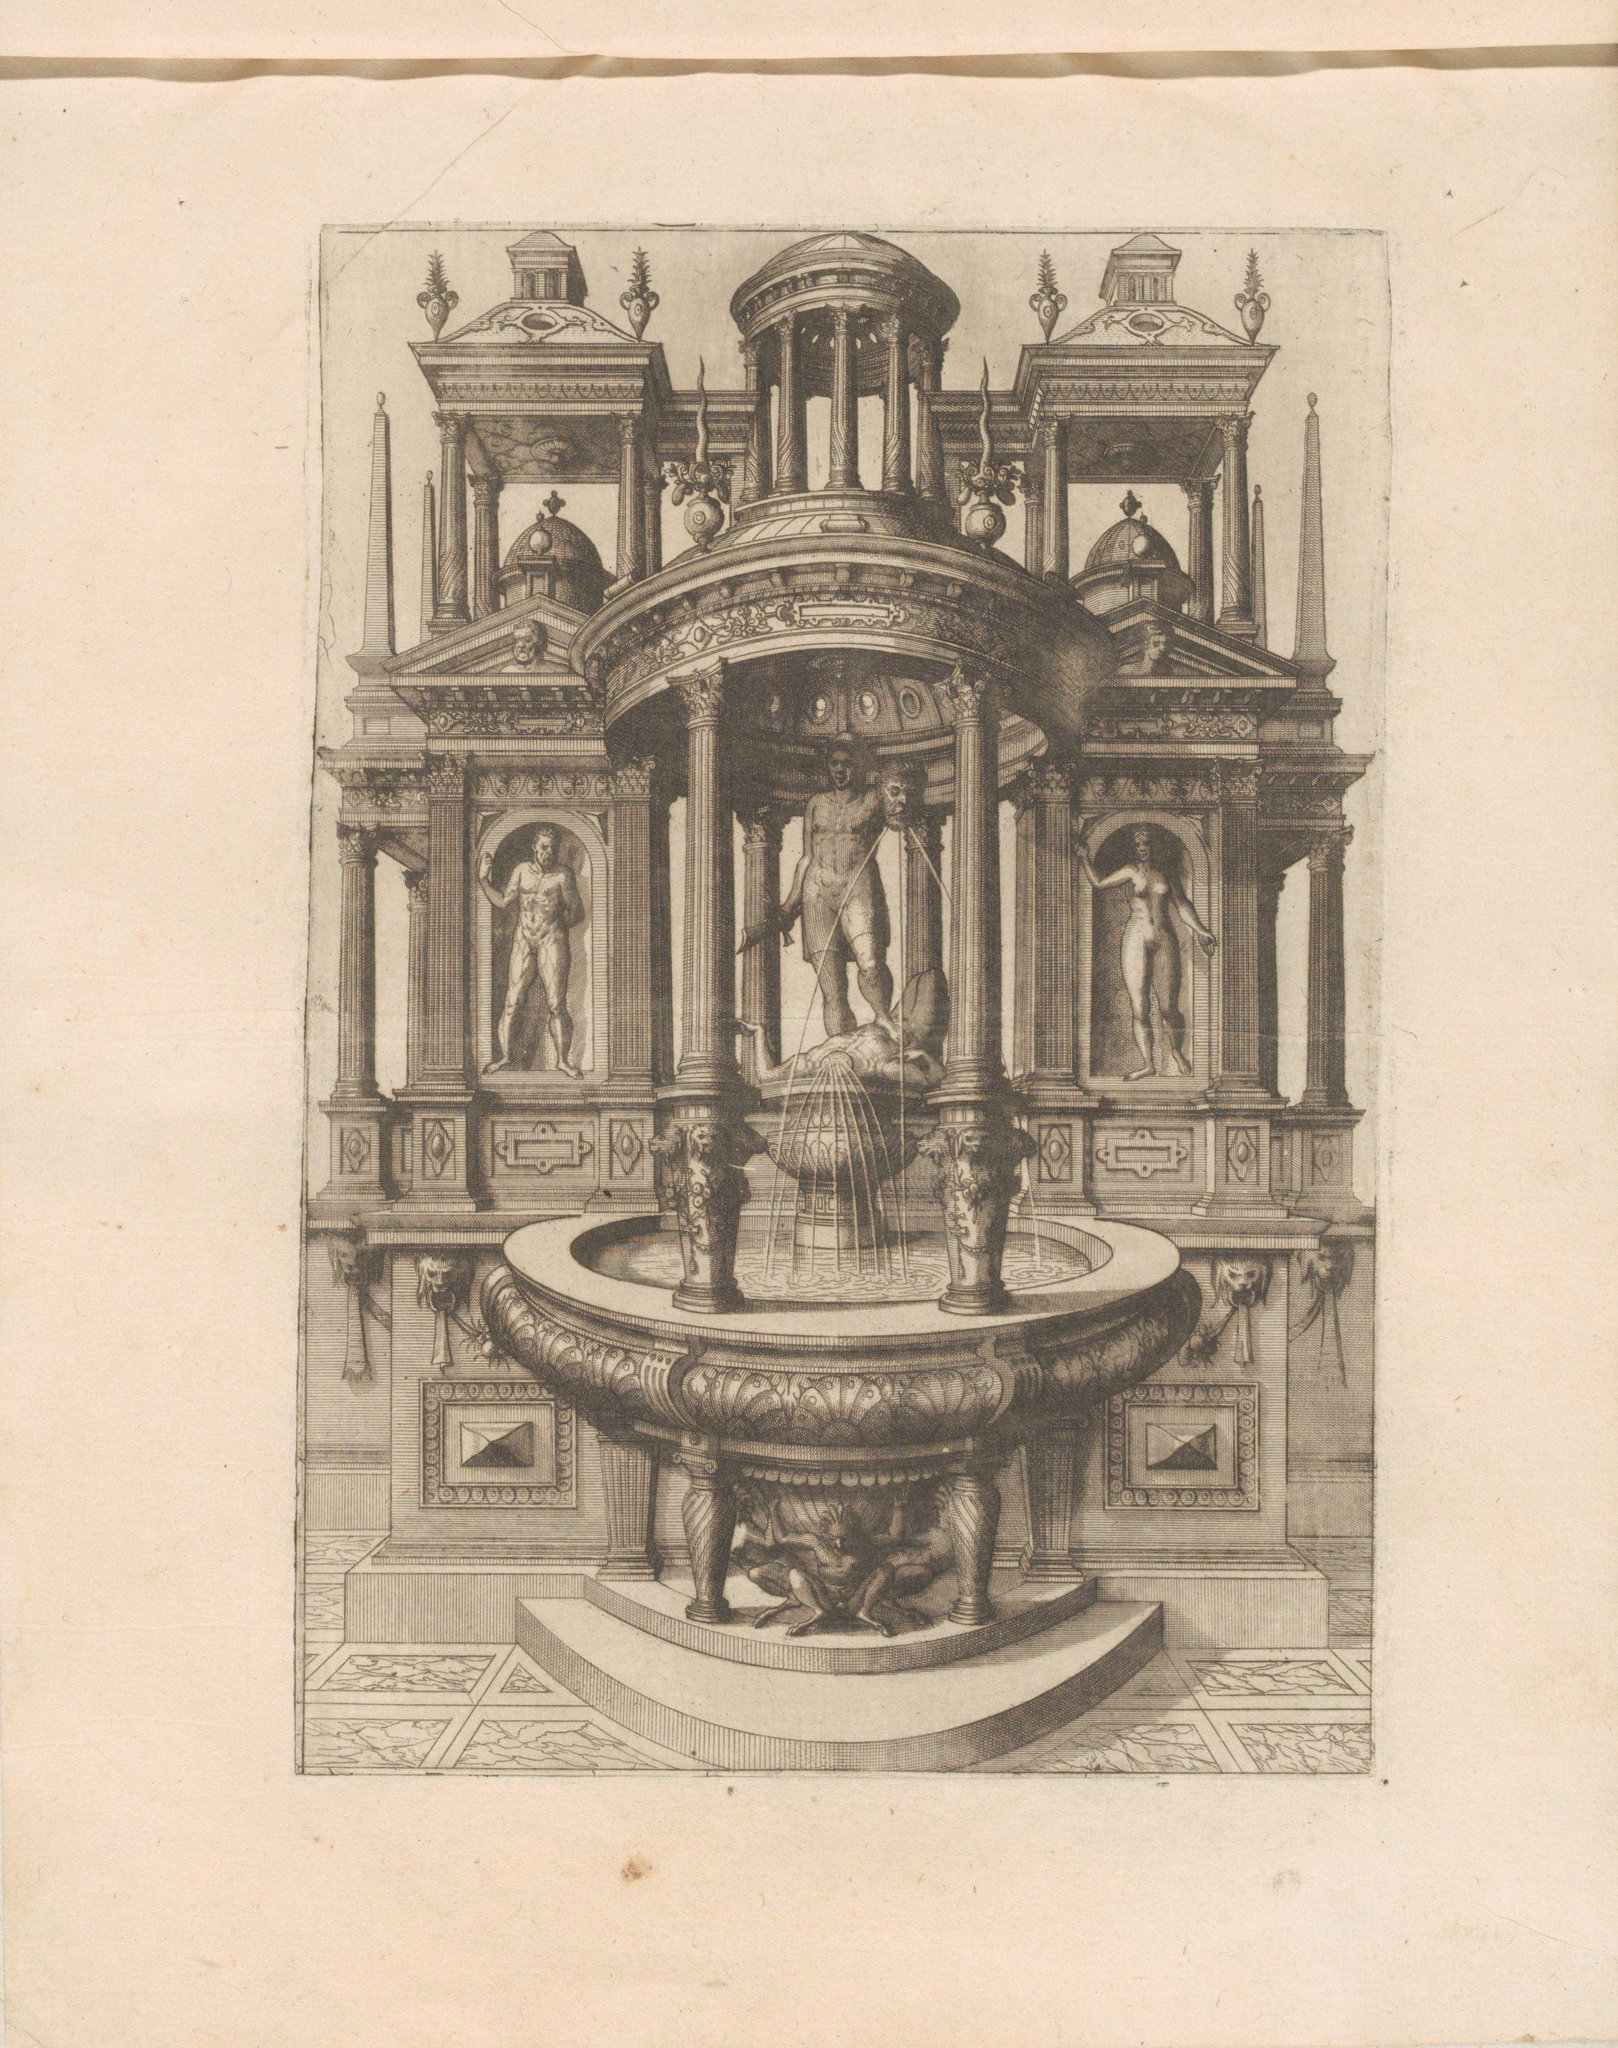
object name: print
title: Ronde fontein met een beeld van een man met een afgehouwen hoofd in de hand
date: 1568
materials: paper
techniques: etching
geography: antwerp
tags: ornamental fountain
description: Ronde fontein met een beeld van een man met een afgehouwen mannenhoofd in de hand. Deze prent maakt deel uit van een album.